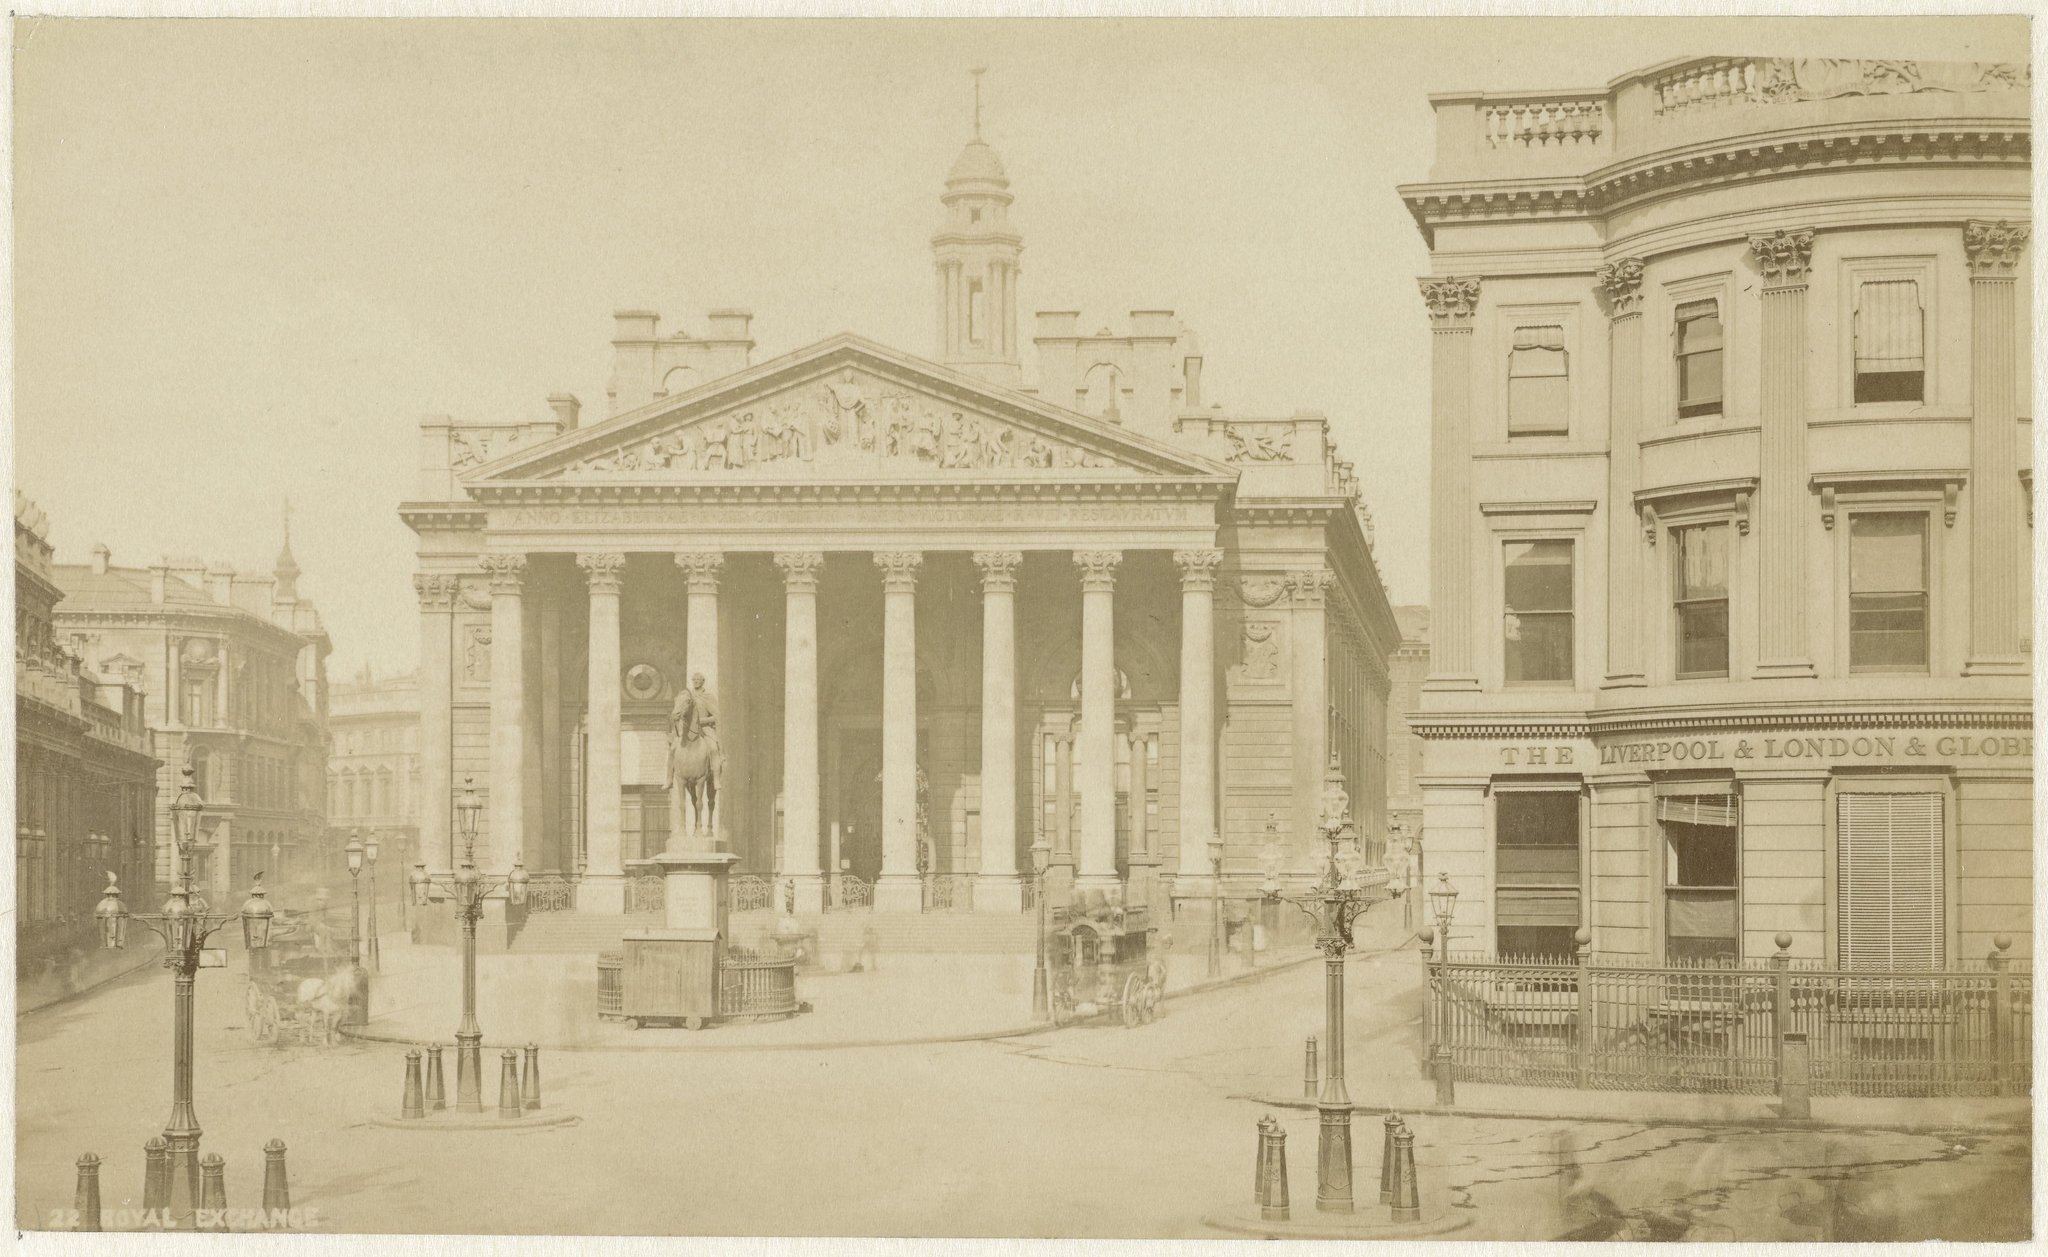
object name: photograph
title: Royal Exchange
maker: Anonymous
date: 1851-1900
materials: paper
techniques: albumen print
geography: london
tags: stock exchange, stock-market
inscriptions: number: ‘22’